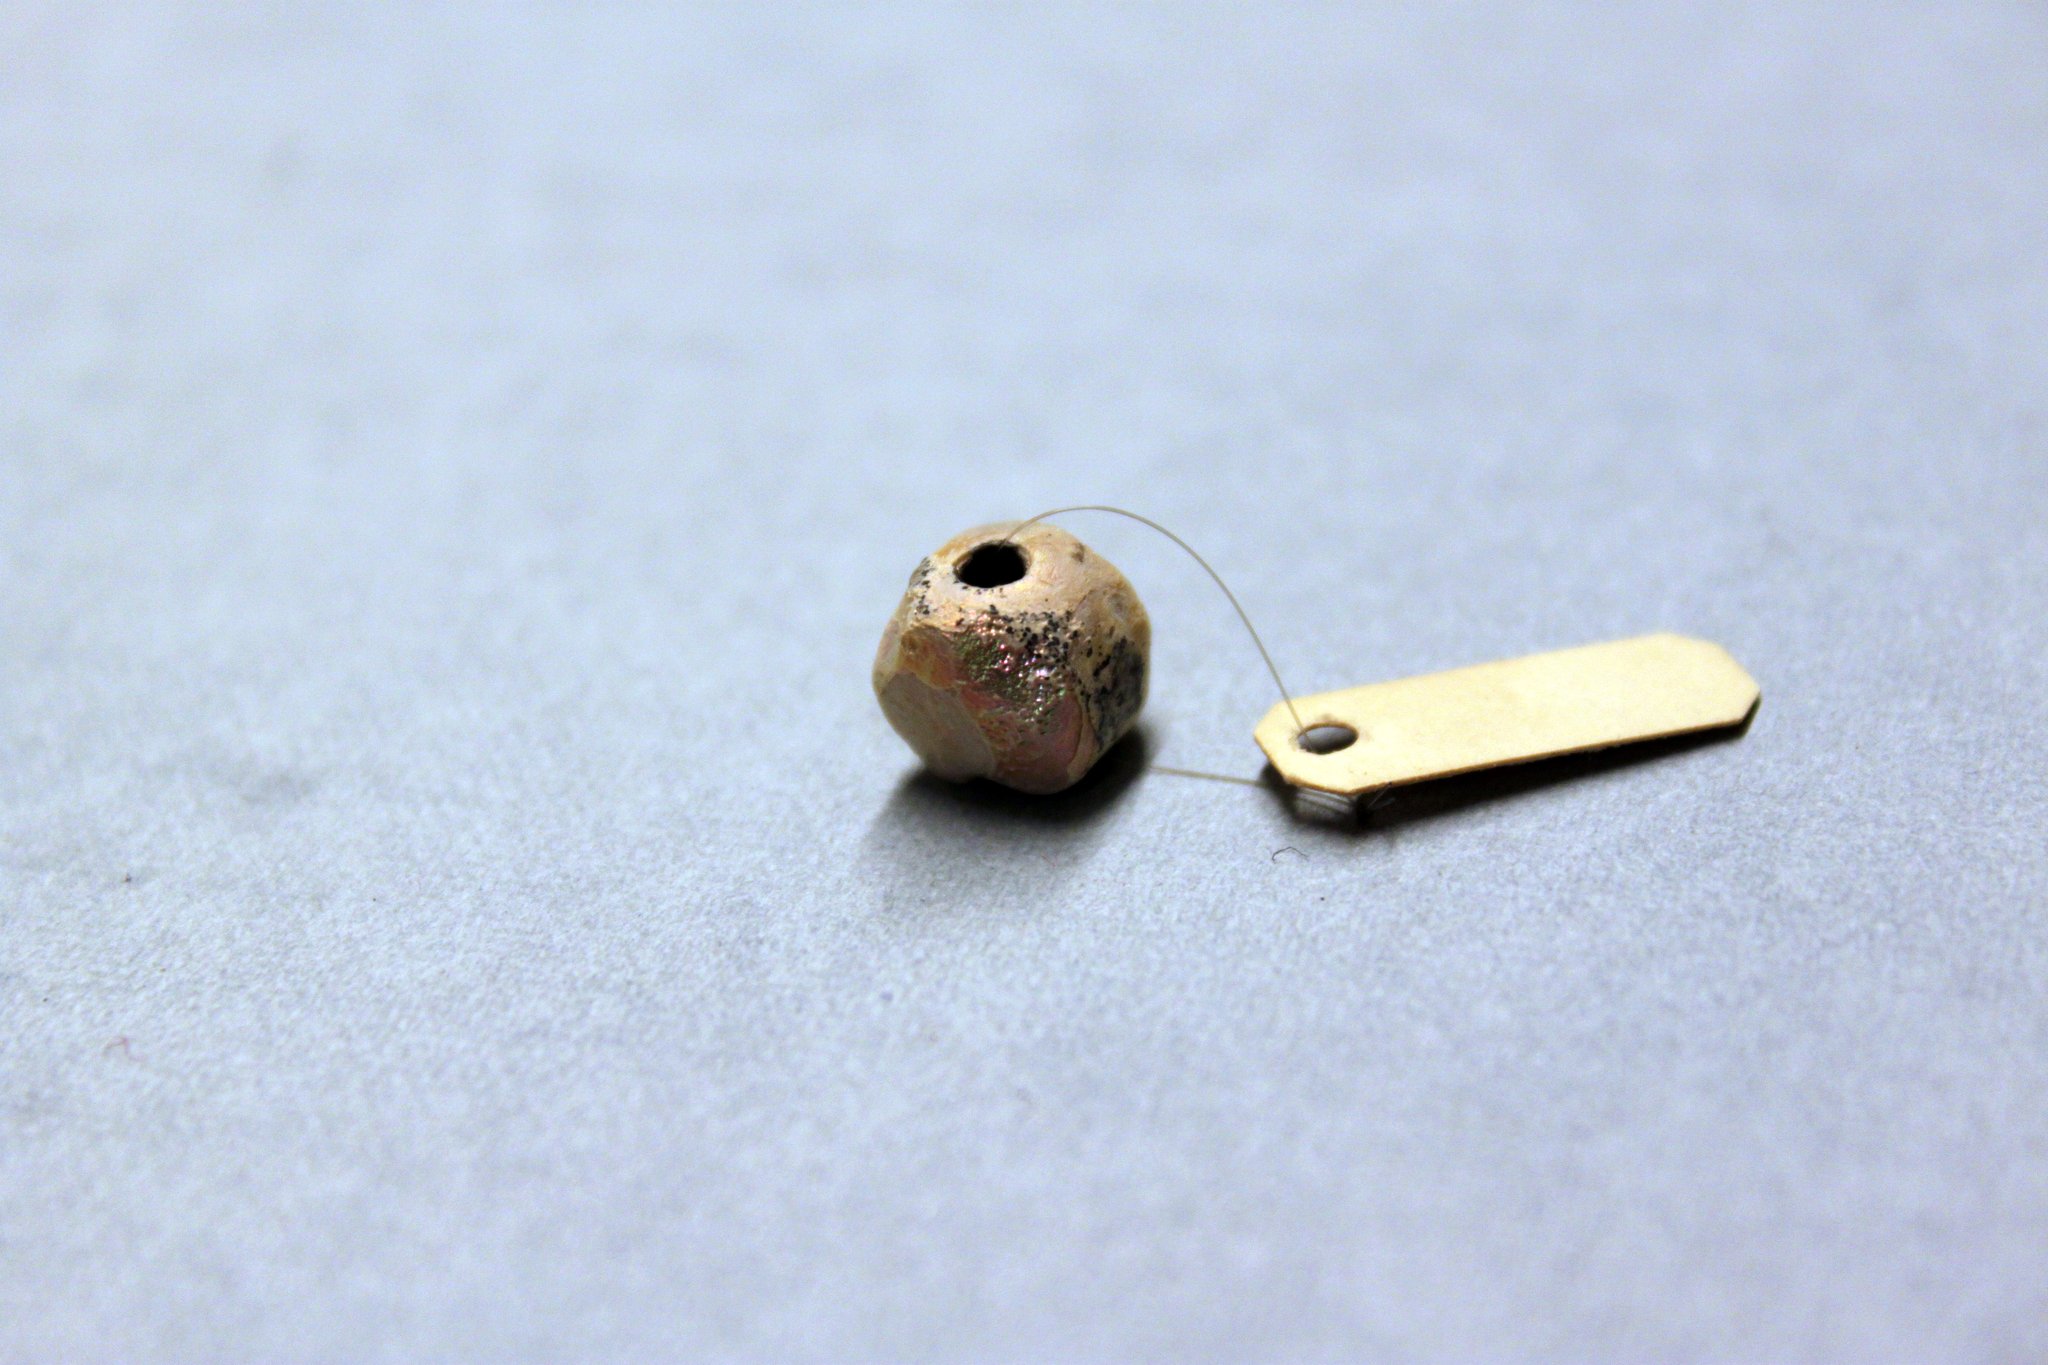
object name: bead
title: Beads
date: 701-1300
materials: glass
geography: iran